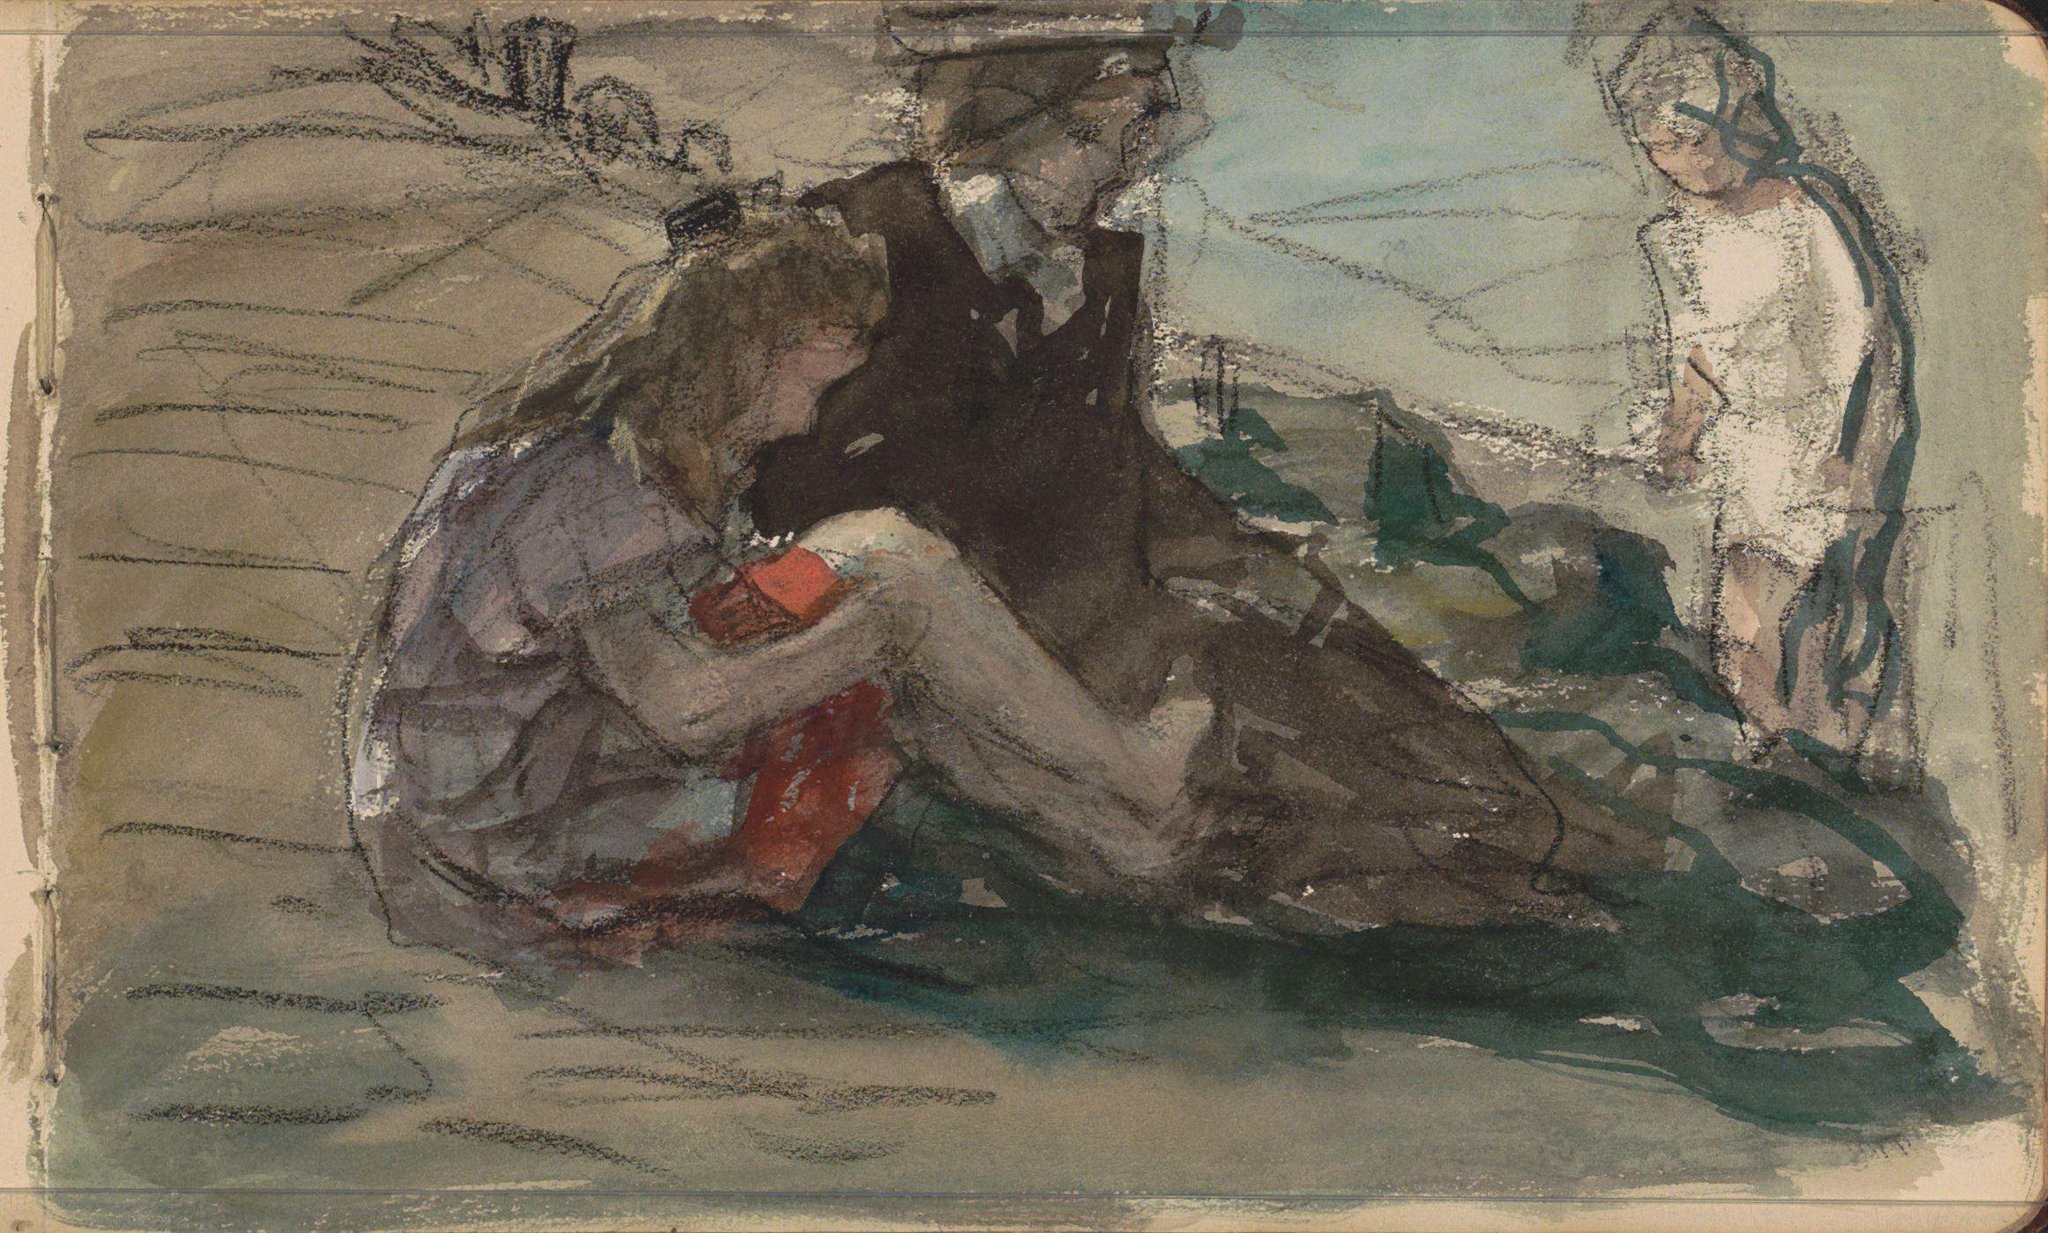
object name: sketchbook leaf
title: Vrouw met twee kinderen langs de waterkant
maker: johan antonie de jonge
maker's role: draughtsman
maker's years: 1864-1927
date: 1881-1927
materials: chalk, paper, watercolor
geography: south holland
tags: landscapes with waters, waterscapes, seascapes (in the temperate zone), mother and child(ren), woman and child(ren) (family group)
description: Een vrouw zit langs de waterkant. Naast haar zit een meisje. Rechts staat een kind. Blad 31 uit een schetsboek met 34 bladen.